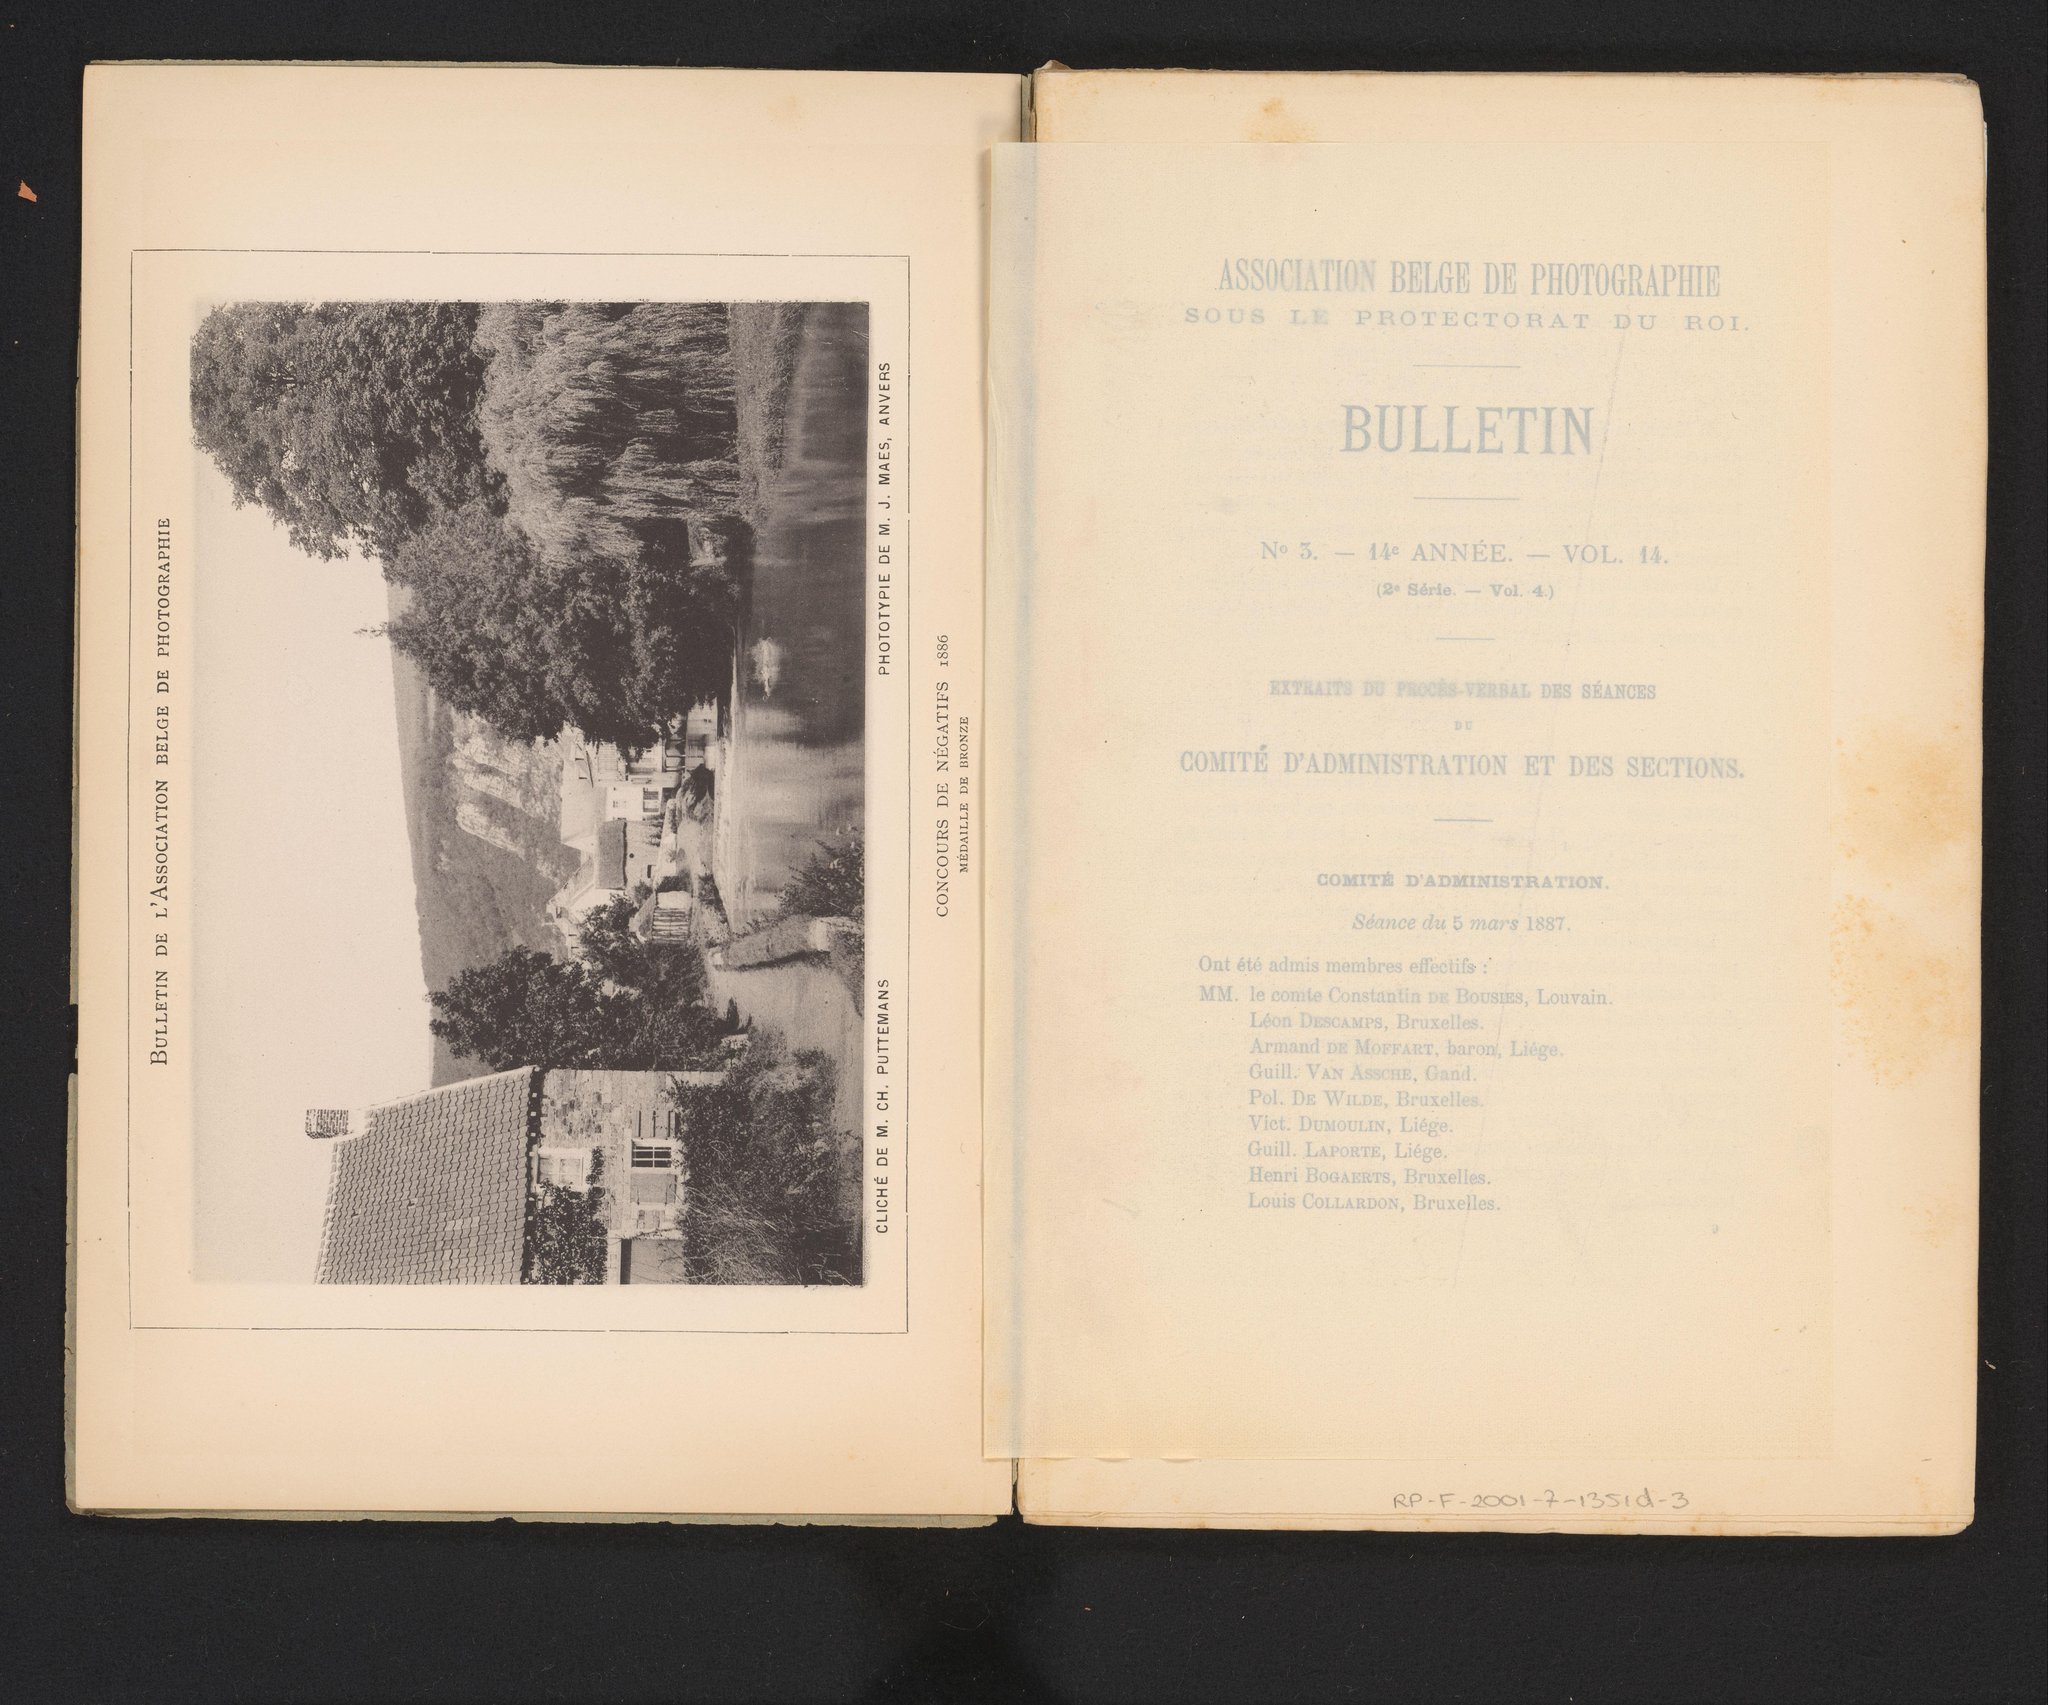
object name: photomechanical print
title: Gezicht op huizen langs een rivier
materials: paper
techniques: photograph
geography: antwerp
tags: river, civic architecture; edifices; dwellings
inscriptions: inscription: ‘CONCOURS DE NÉGATIFS 1886/ MÉDAILLE DE BRONZE’, inscription: ‘Bulletin de l'Association belge de photographie’